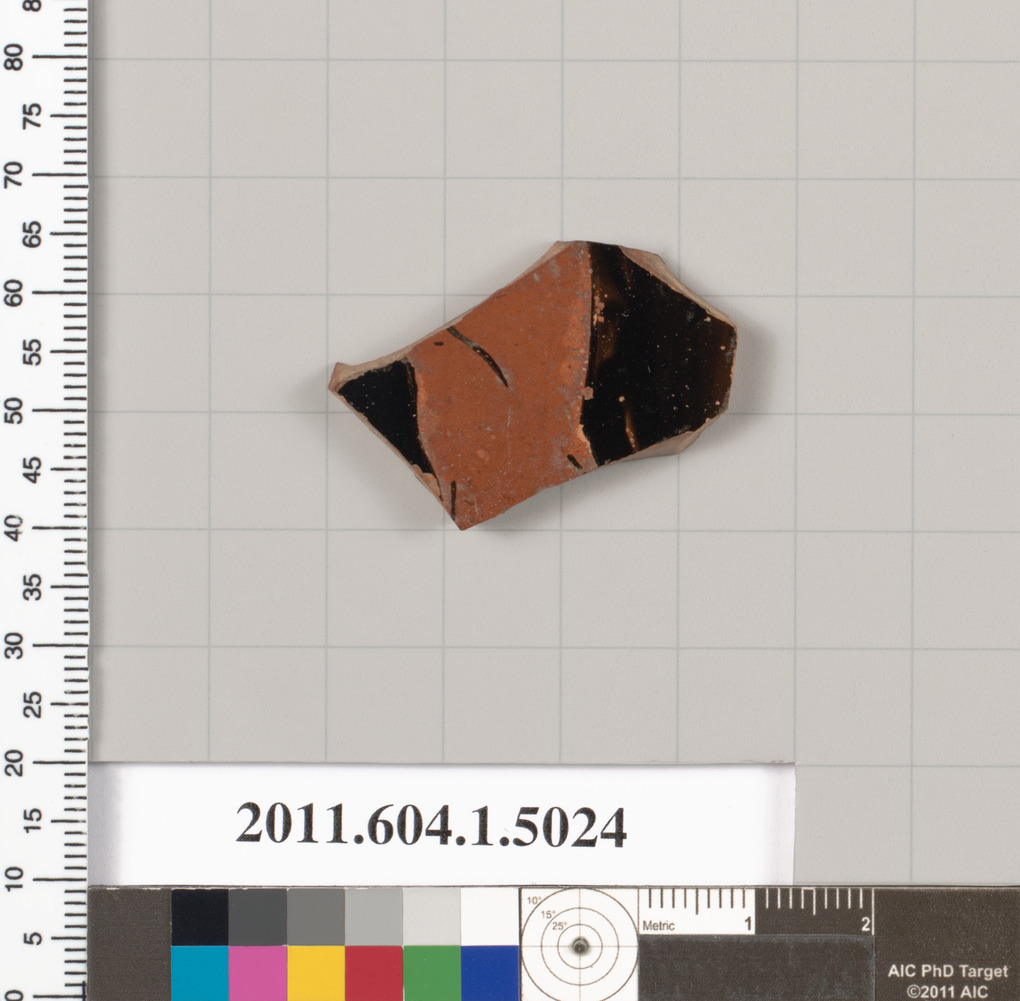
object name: kylix fragment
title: Terracotta fragment of a kylix (drinking cup)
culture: greek, attic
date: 500-480 BCE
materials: terracotta